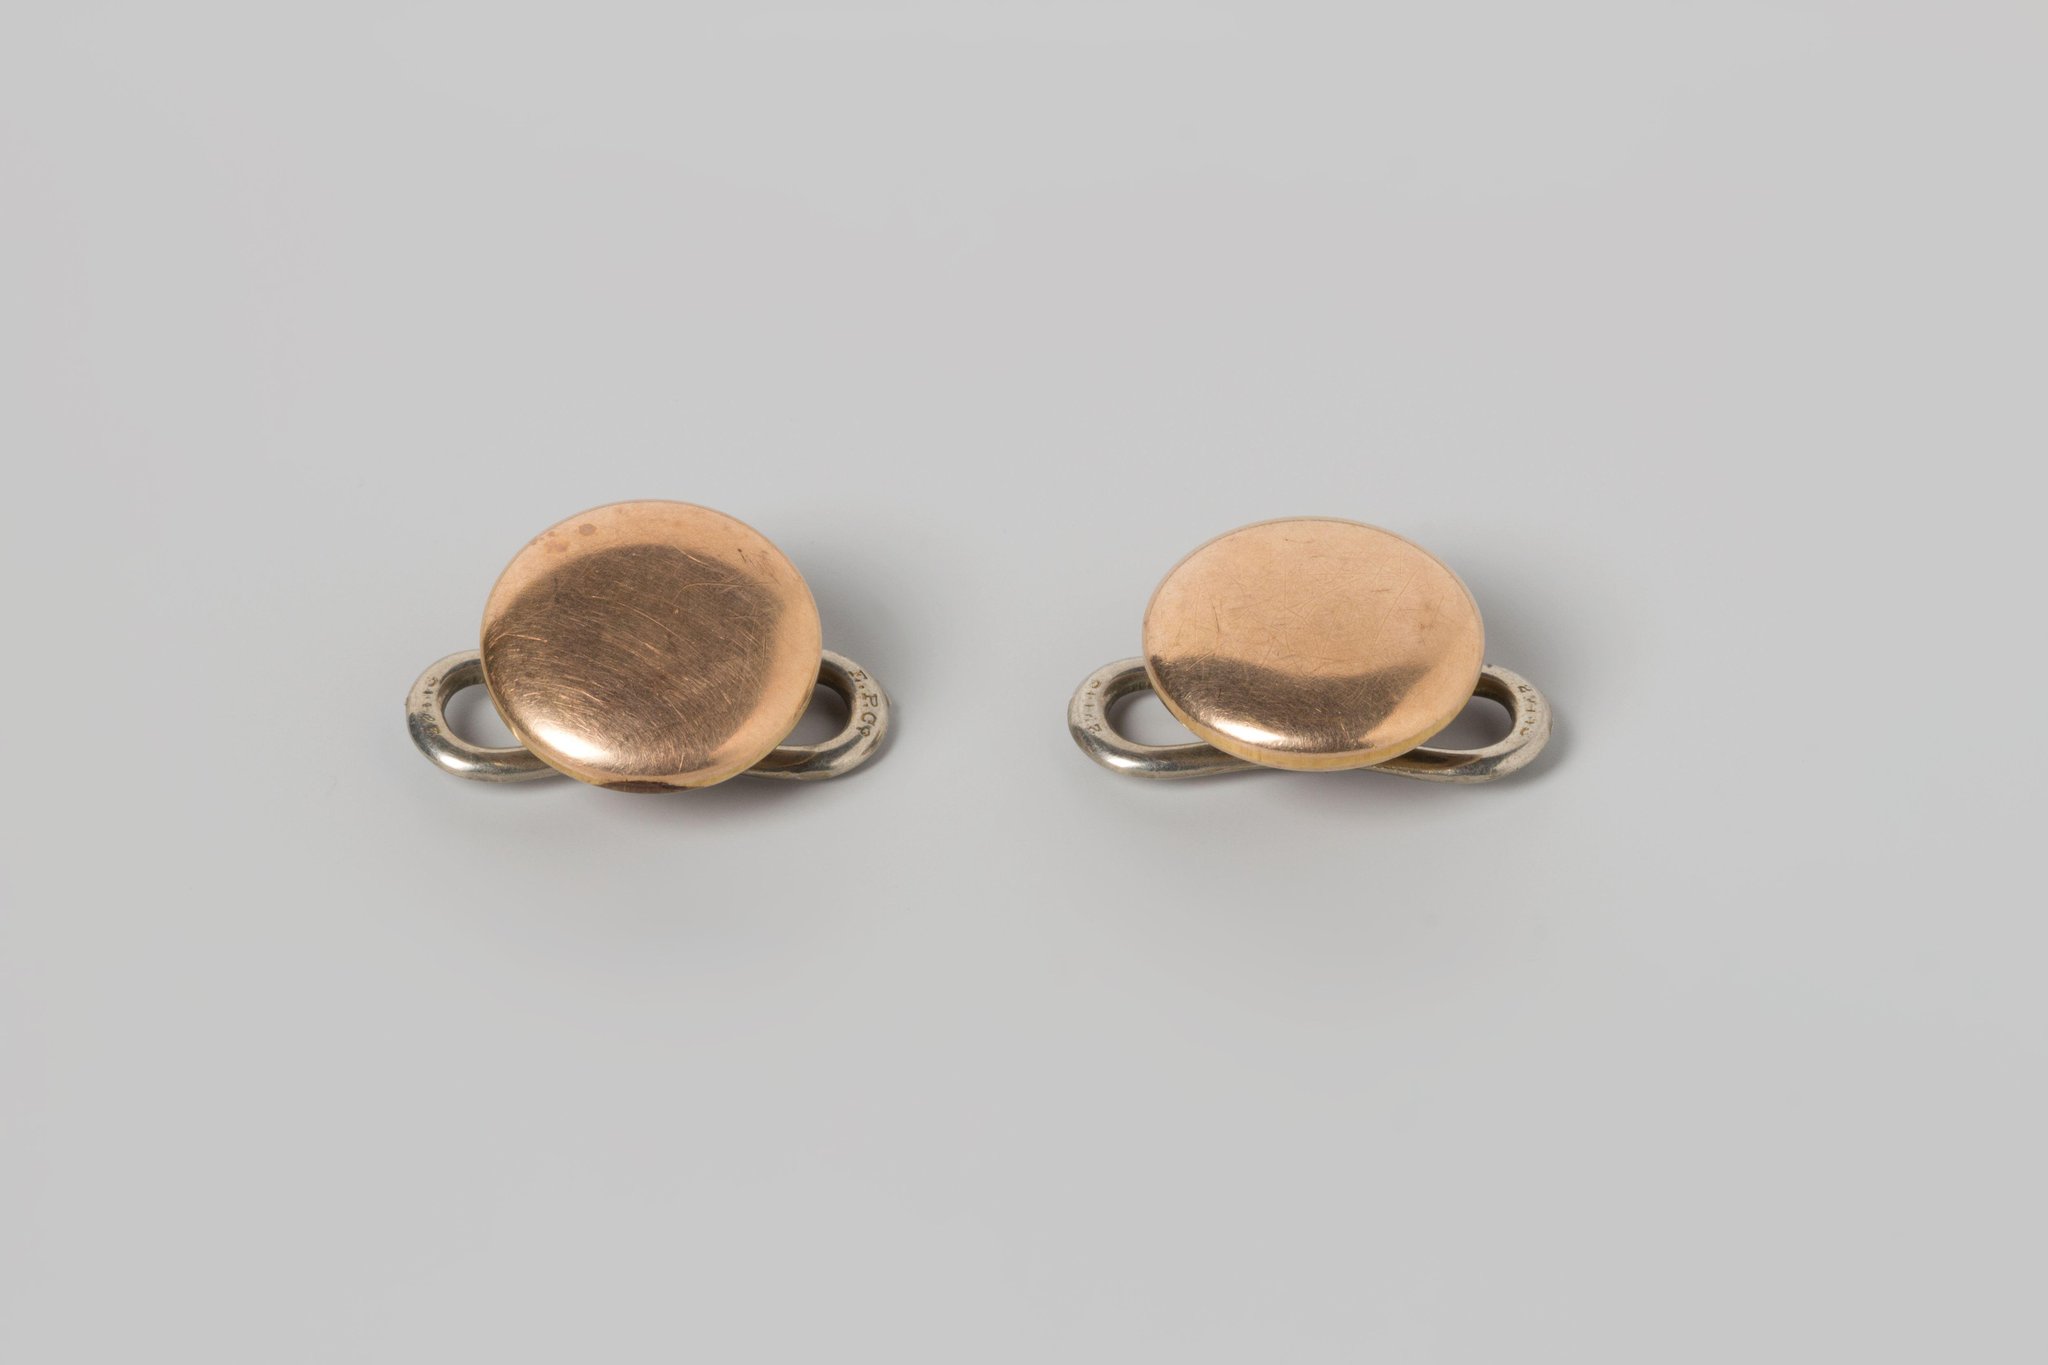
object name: menswear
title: Vestknoop van metaal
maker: Anonymous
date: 1900-1940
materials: metal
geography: netherlands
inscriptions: mark: ‘F.P.Co’